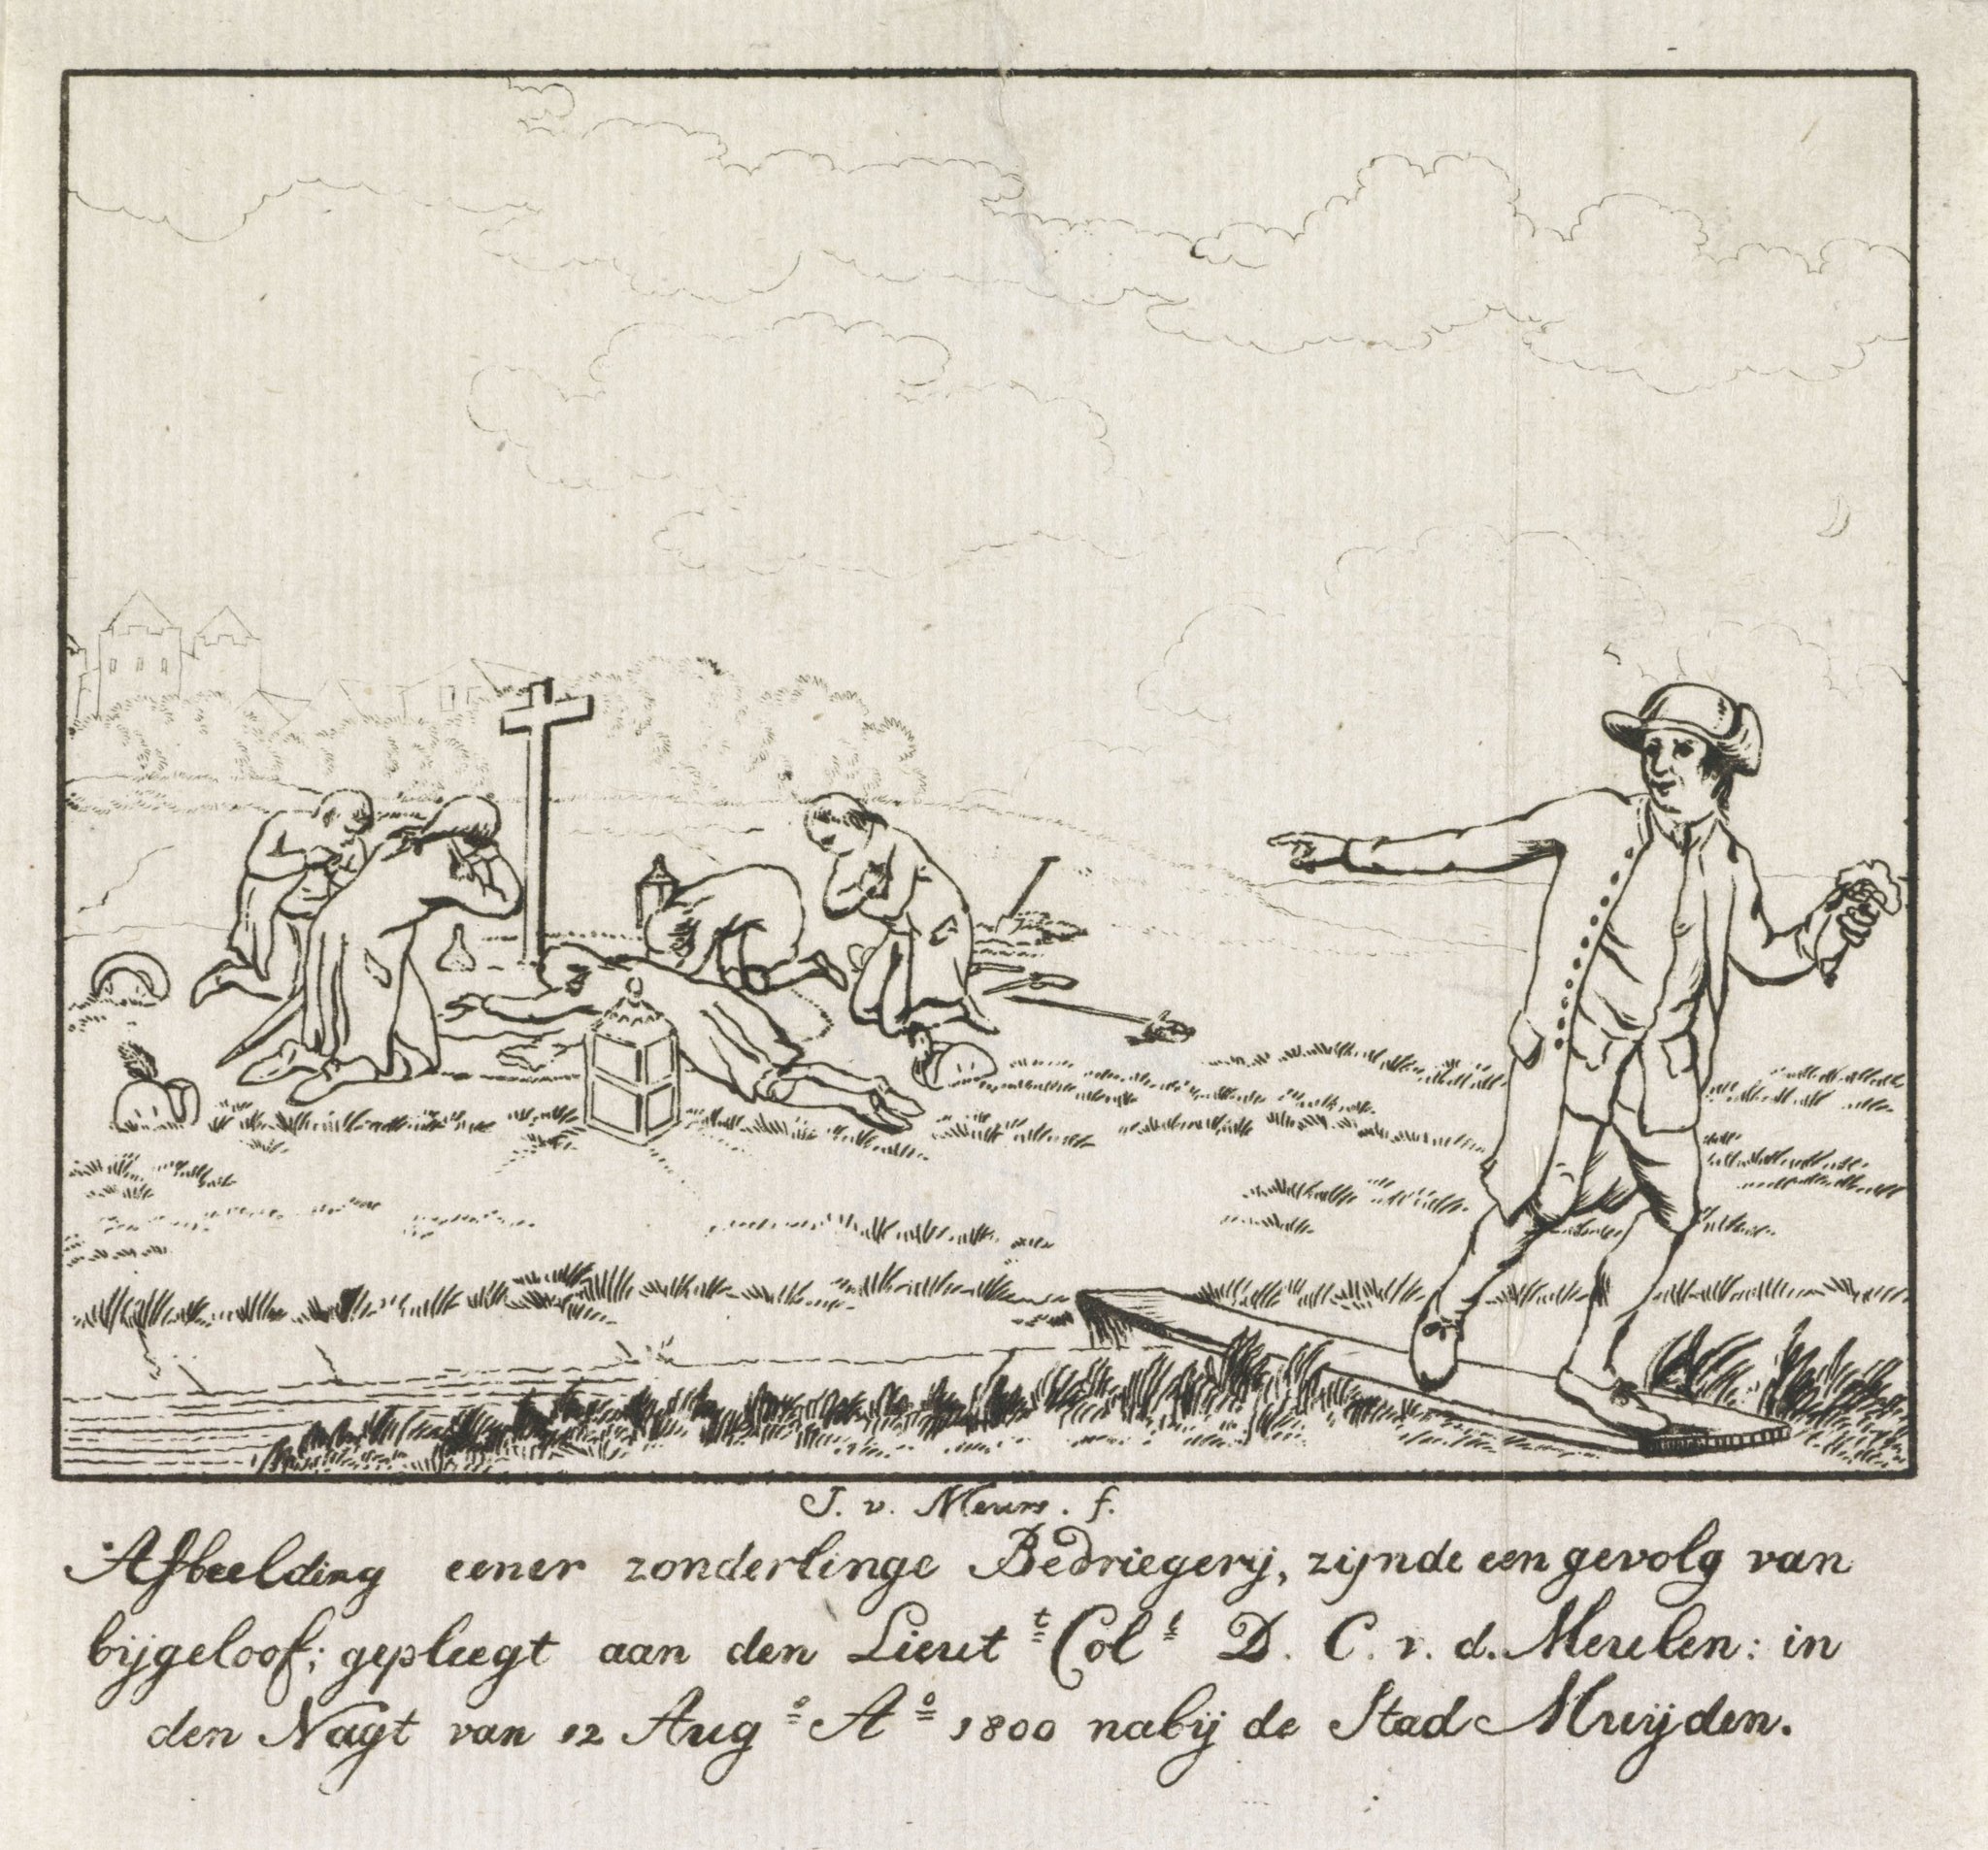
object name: print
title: Schatzoekers van Muiden, 1800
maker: jacobus van meurs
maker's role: draughtsman, painter, print maker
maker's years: 1760-1824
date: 1800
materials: paper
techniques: etching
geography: netherlands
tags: amsterdam, digging for or finding of treasure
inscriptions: collector's mark: Lugt 2228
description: De schatzoekers van Muiden bidden rond het kruis op de plaats van de vermeende schat. De Duitse oplichter gaat er lachend wijzend vandoor met de zak geld. Illustratie van het verhaal van het bedrog van de bijgelovige katholieke luitenant-kolonel Dirk Cornelis van der Meulen door een Duitse oplichter, te Muiden in de nacht van 12 op 13 augustus 1800. Op de achtergrond het Muiderslot. Op het blad onder de plaat een vers in twee kolommen.